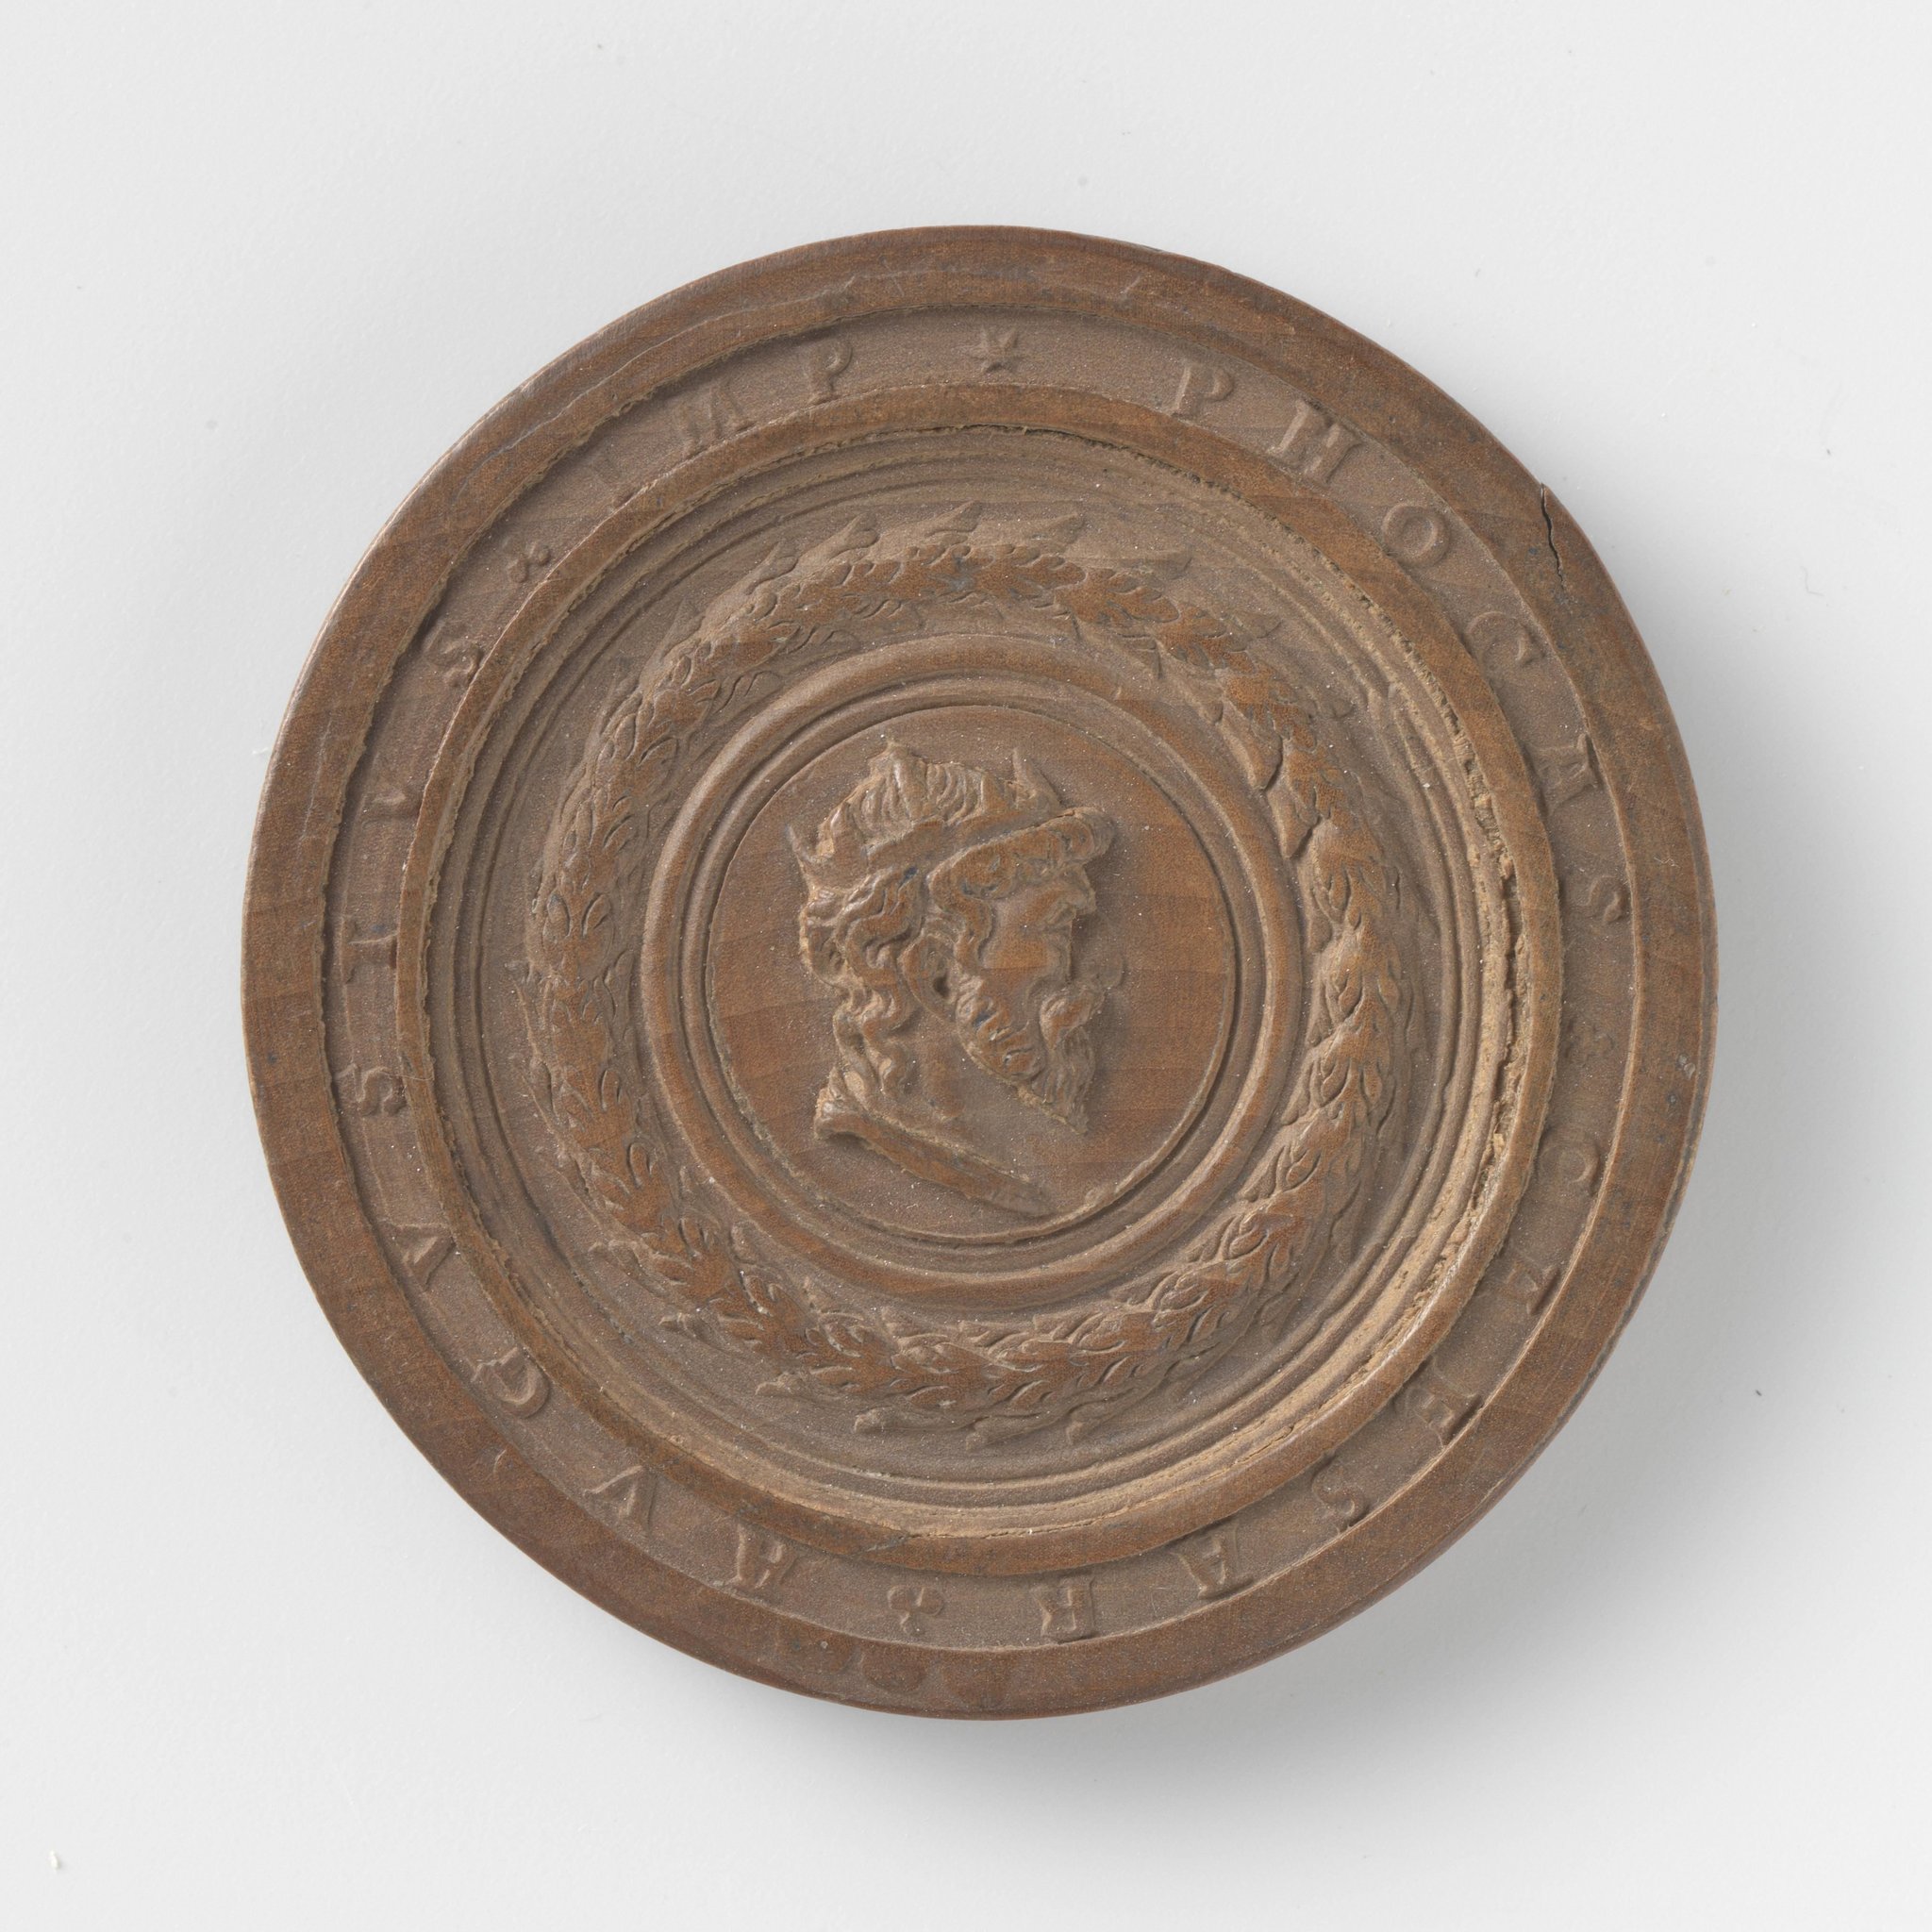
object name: checker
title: Helft van damschijf met portret: Phocas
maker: Anonymous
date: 1525-1575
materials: wood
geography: nuremberg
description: PHOCAS. CAESAR. AVGVSTVS. IMP. (Phocas, Oostromeins keizer van 602-610)